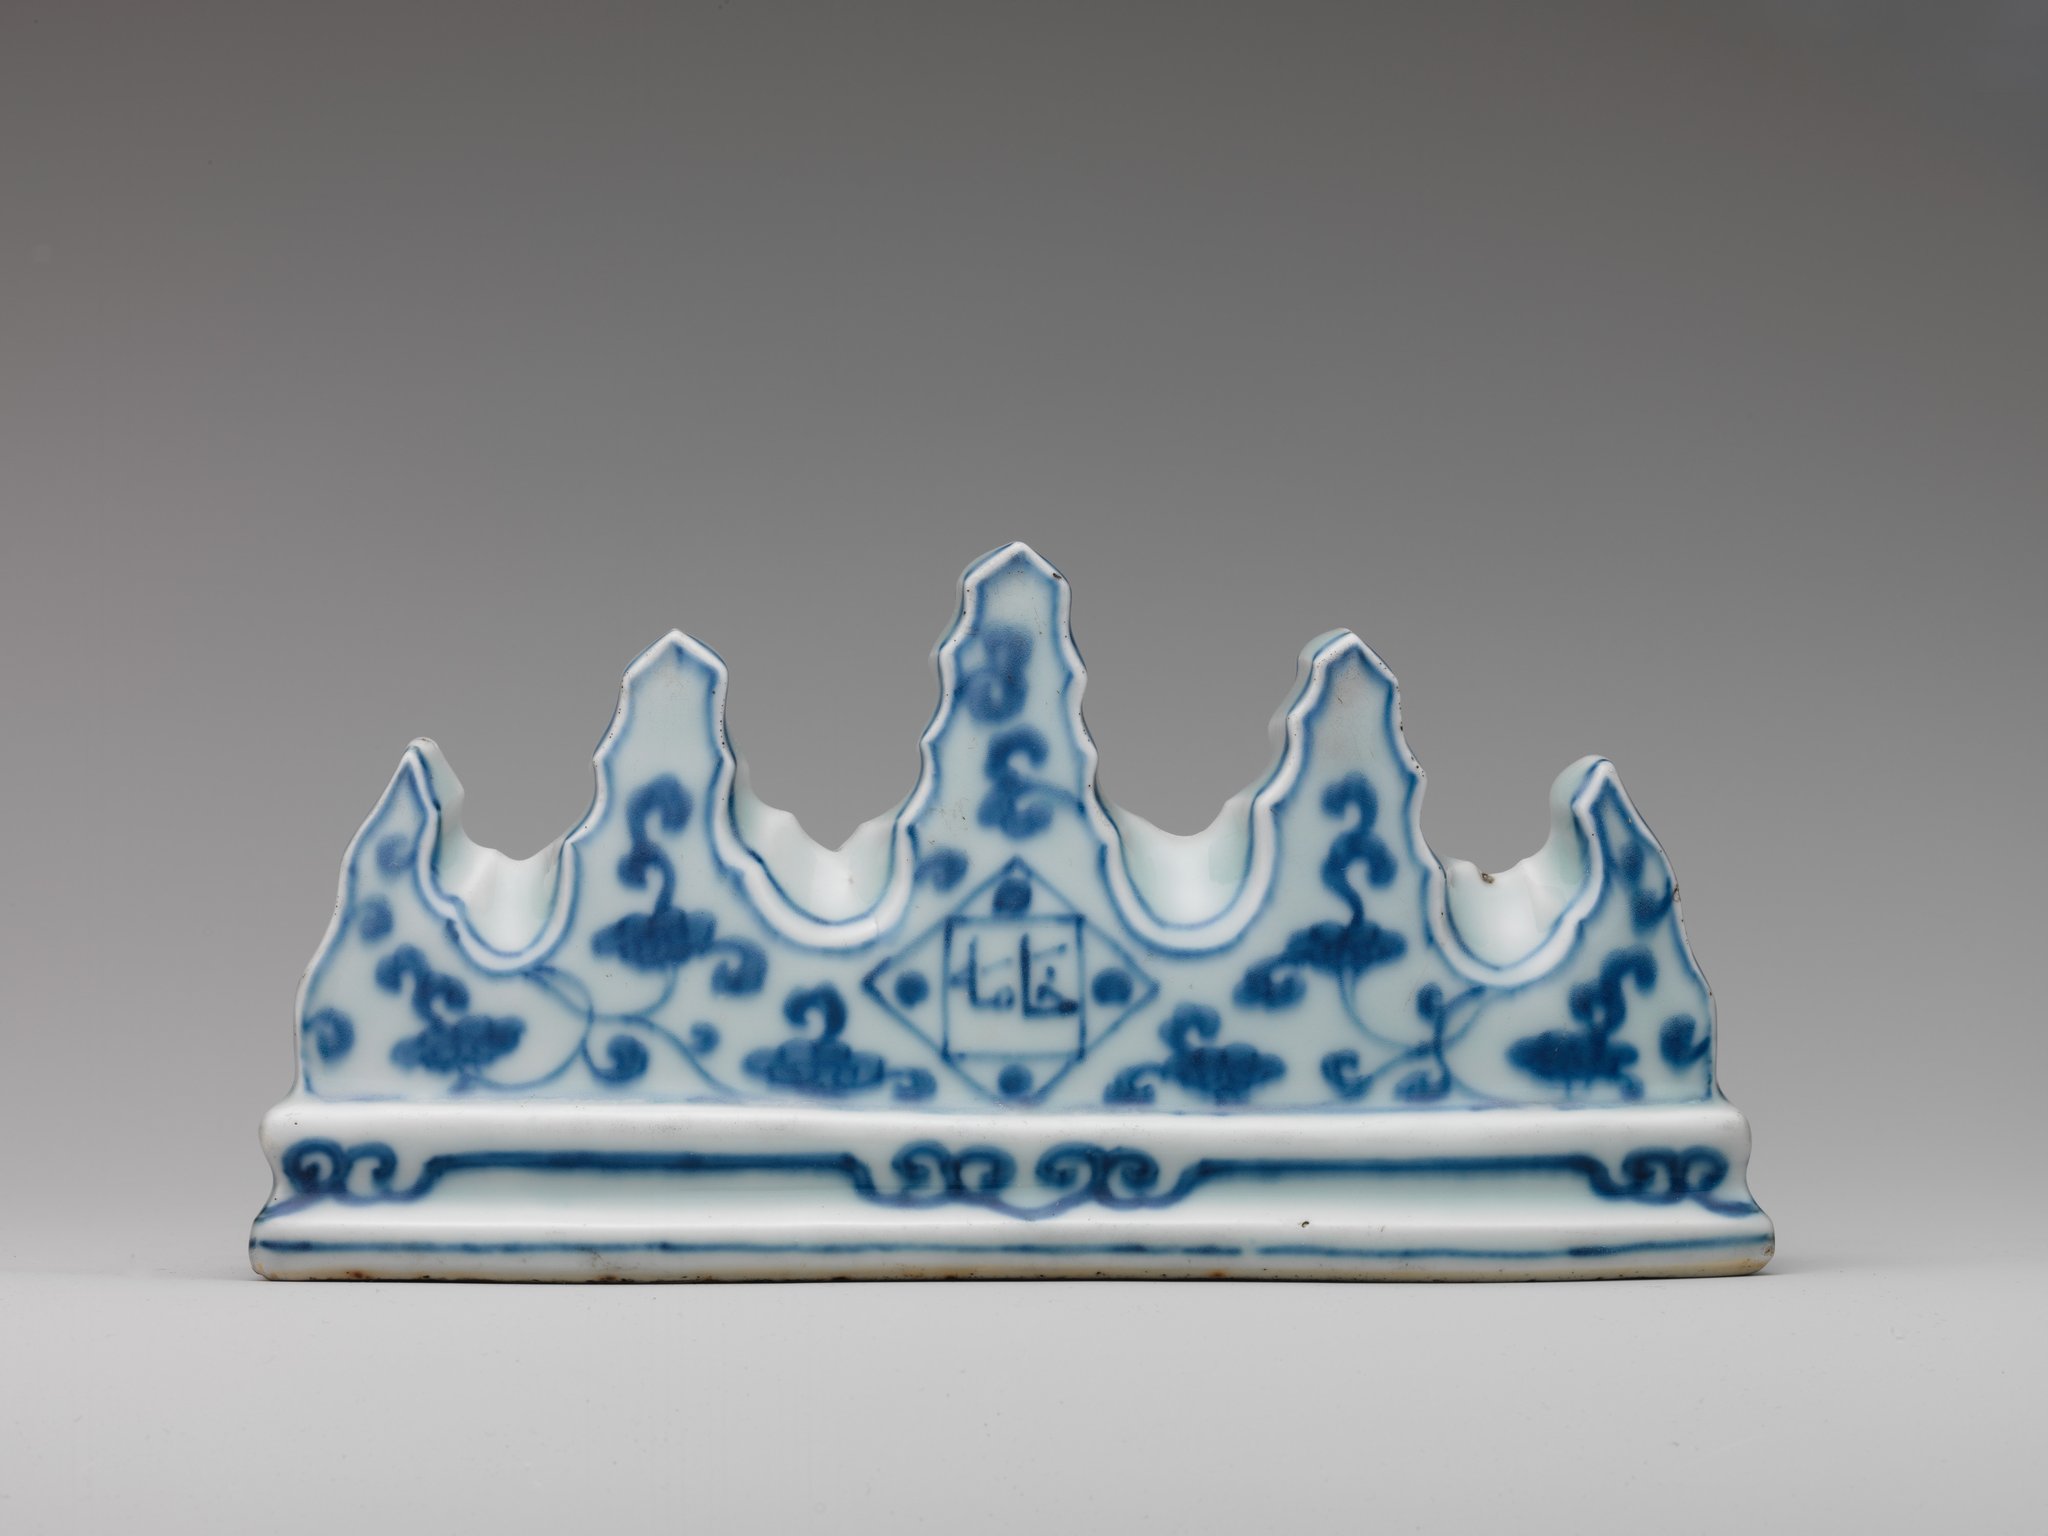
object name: brush rest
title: Brush Rest with Persian Inscription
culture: chinese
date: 1501-1533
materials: cobalt, glaze, porcelain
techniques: painting